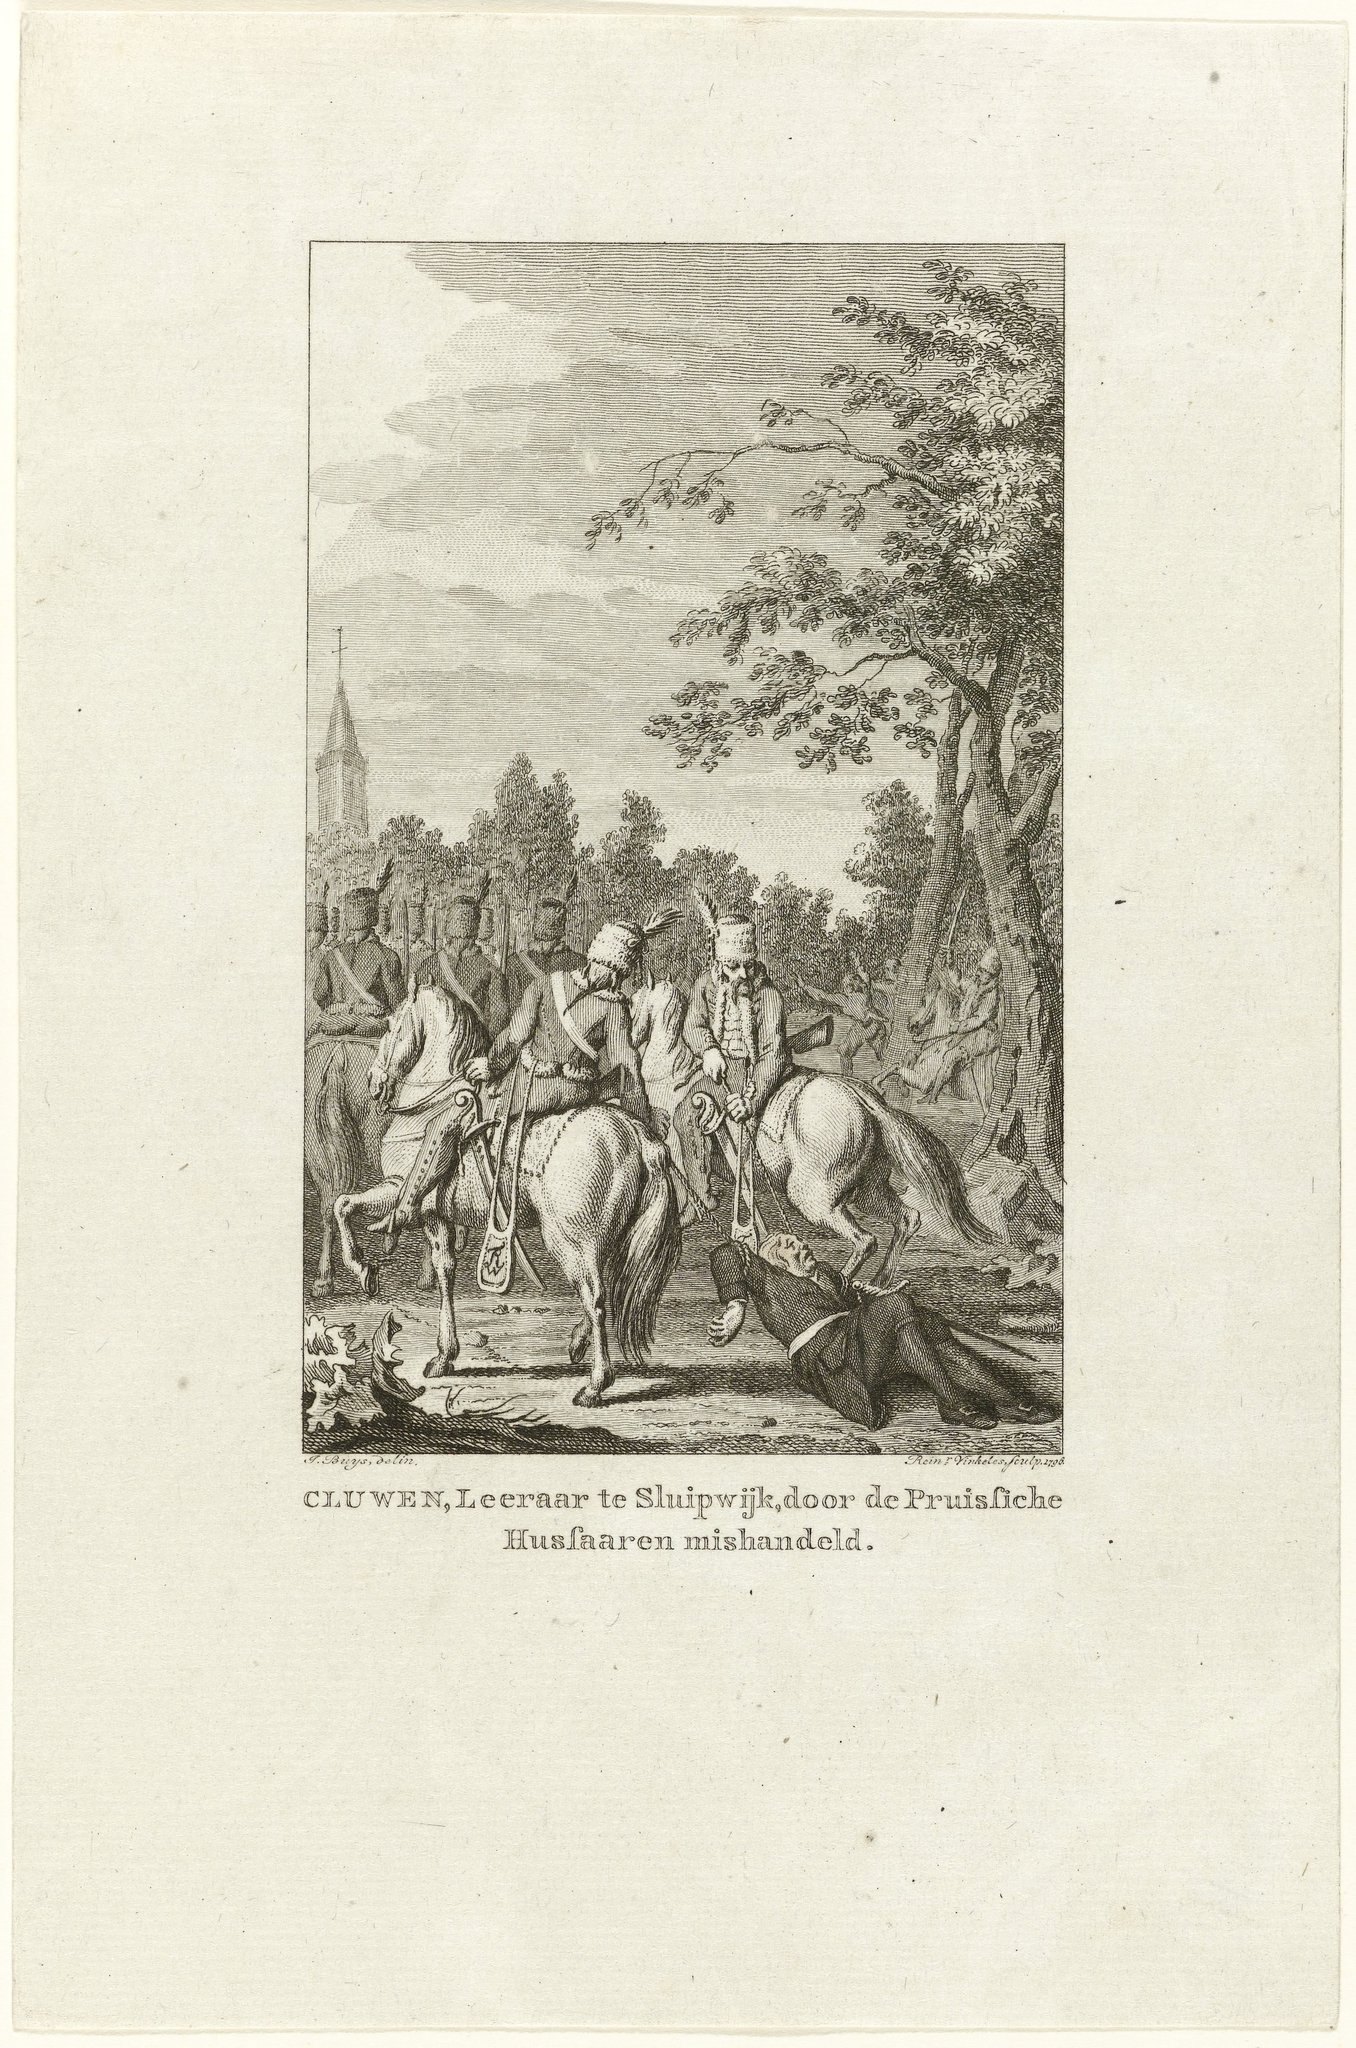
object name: print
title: Mishandeling van dominee Cluwen te Sluipwijk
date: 1796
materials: paper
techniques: engraving, etching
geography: northern netherlands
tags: soldiers and civilians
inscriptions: collector's mark: Lugt 2228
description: Gebruikt als illustratie in: P.A. Loosjes. Vaderlandsche historie, vervattende de geschiedenissen, der Vereenigde Nederlanden (...). Ten onmiddelyken vervolge van Wagenaar's Vaderlandsche historie. Amsterdam: Johannes Allart, dl. 17.